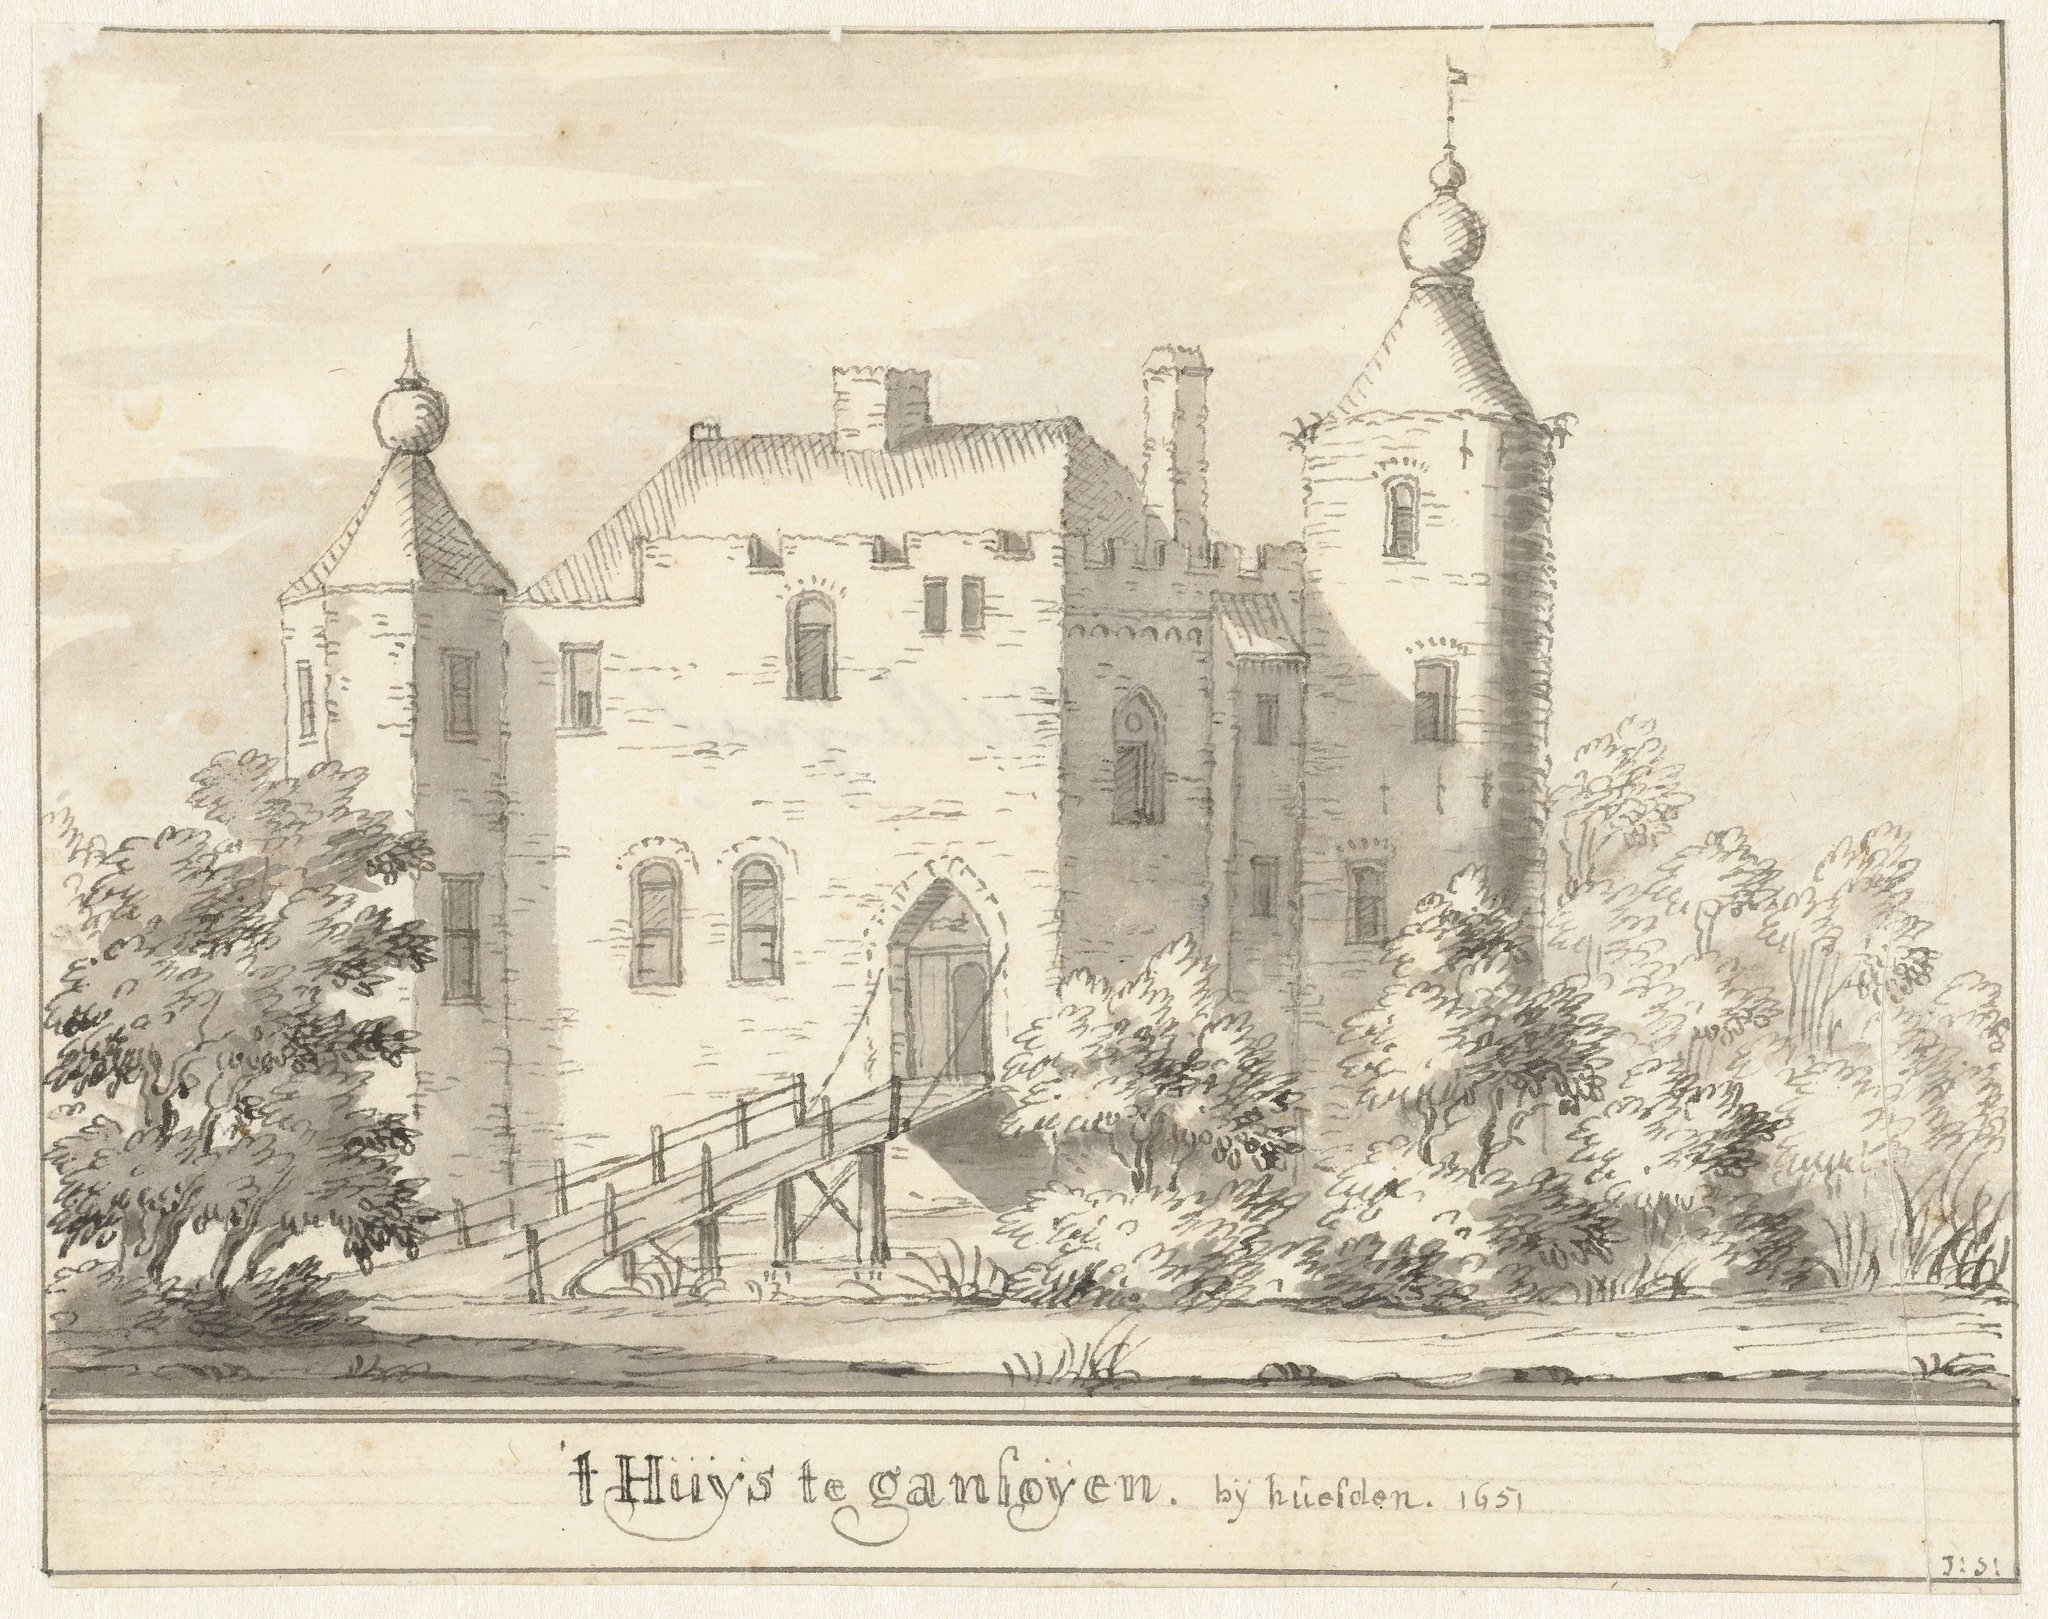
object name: drawing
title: Kasteel Gansoyen bij Heusden in 1651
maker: jacobus stellingwerff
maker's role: draughtsman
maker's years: 1660-1736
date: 1670-1736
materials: ink, paper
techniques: brush, pen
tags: castle, rural housing, e.g. country-house, villa, cottage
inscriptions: inscription: ‘J: S:’, inscription: ‘'t Huijs te gansoijen, bij Huesden, 1651’